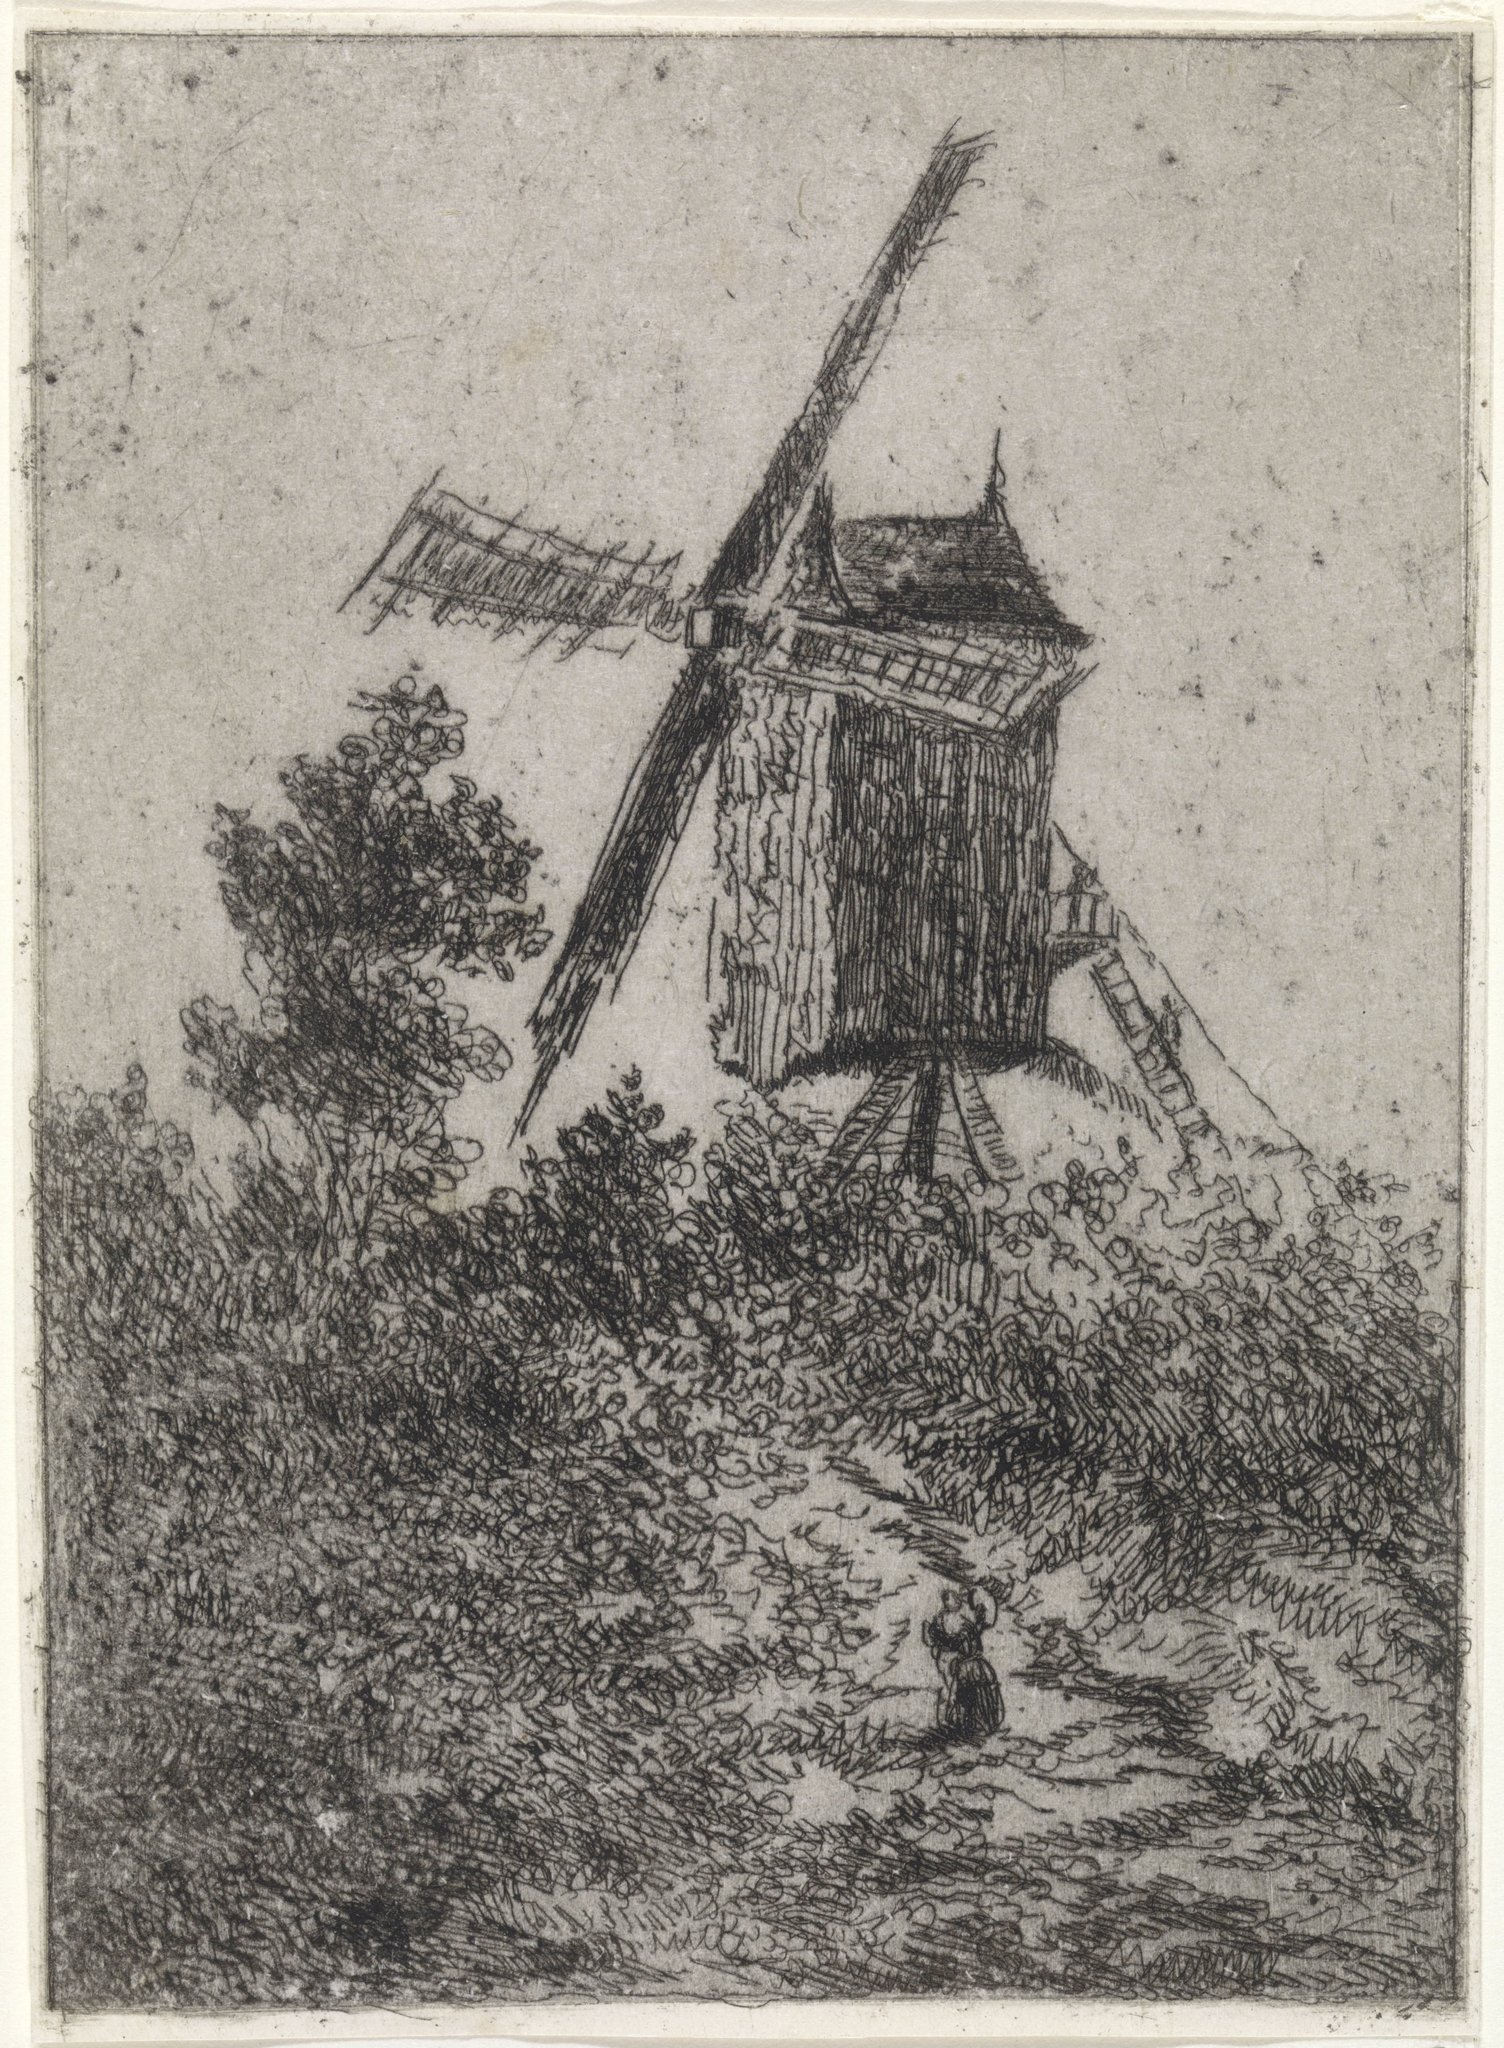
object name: print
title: Windmolen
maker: arnoud schaepkens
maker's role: print maker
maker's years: 1816-1904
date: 1831-1904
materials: paper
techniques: drypoint, etching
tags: windmill in landscape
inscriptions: collector's mark: Lugt 2228